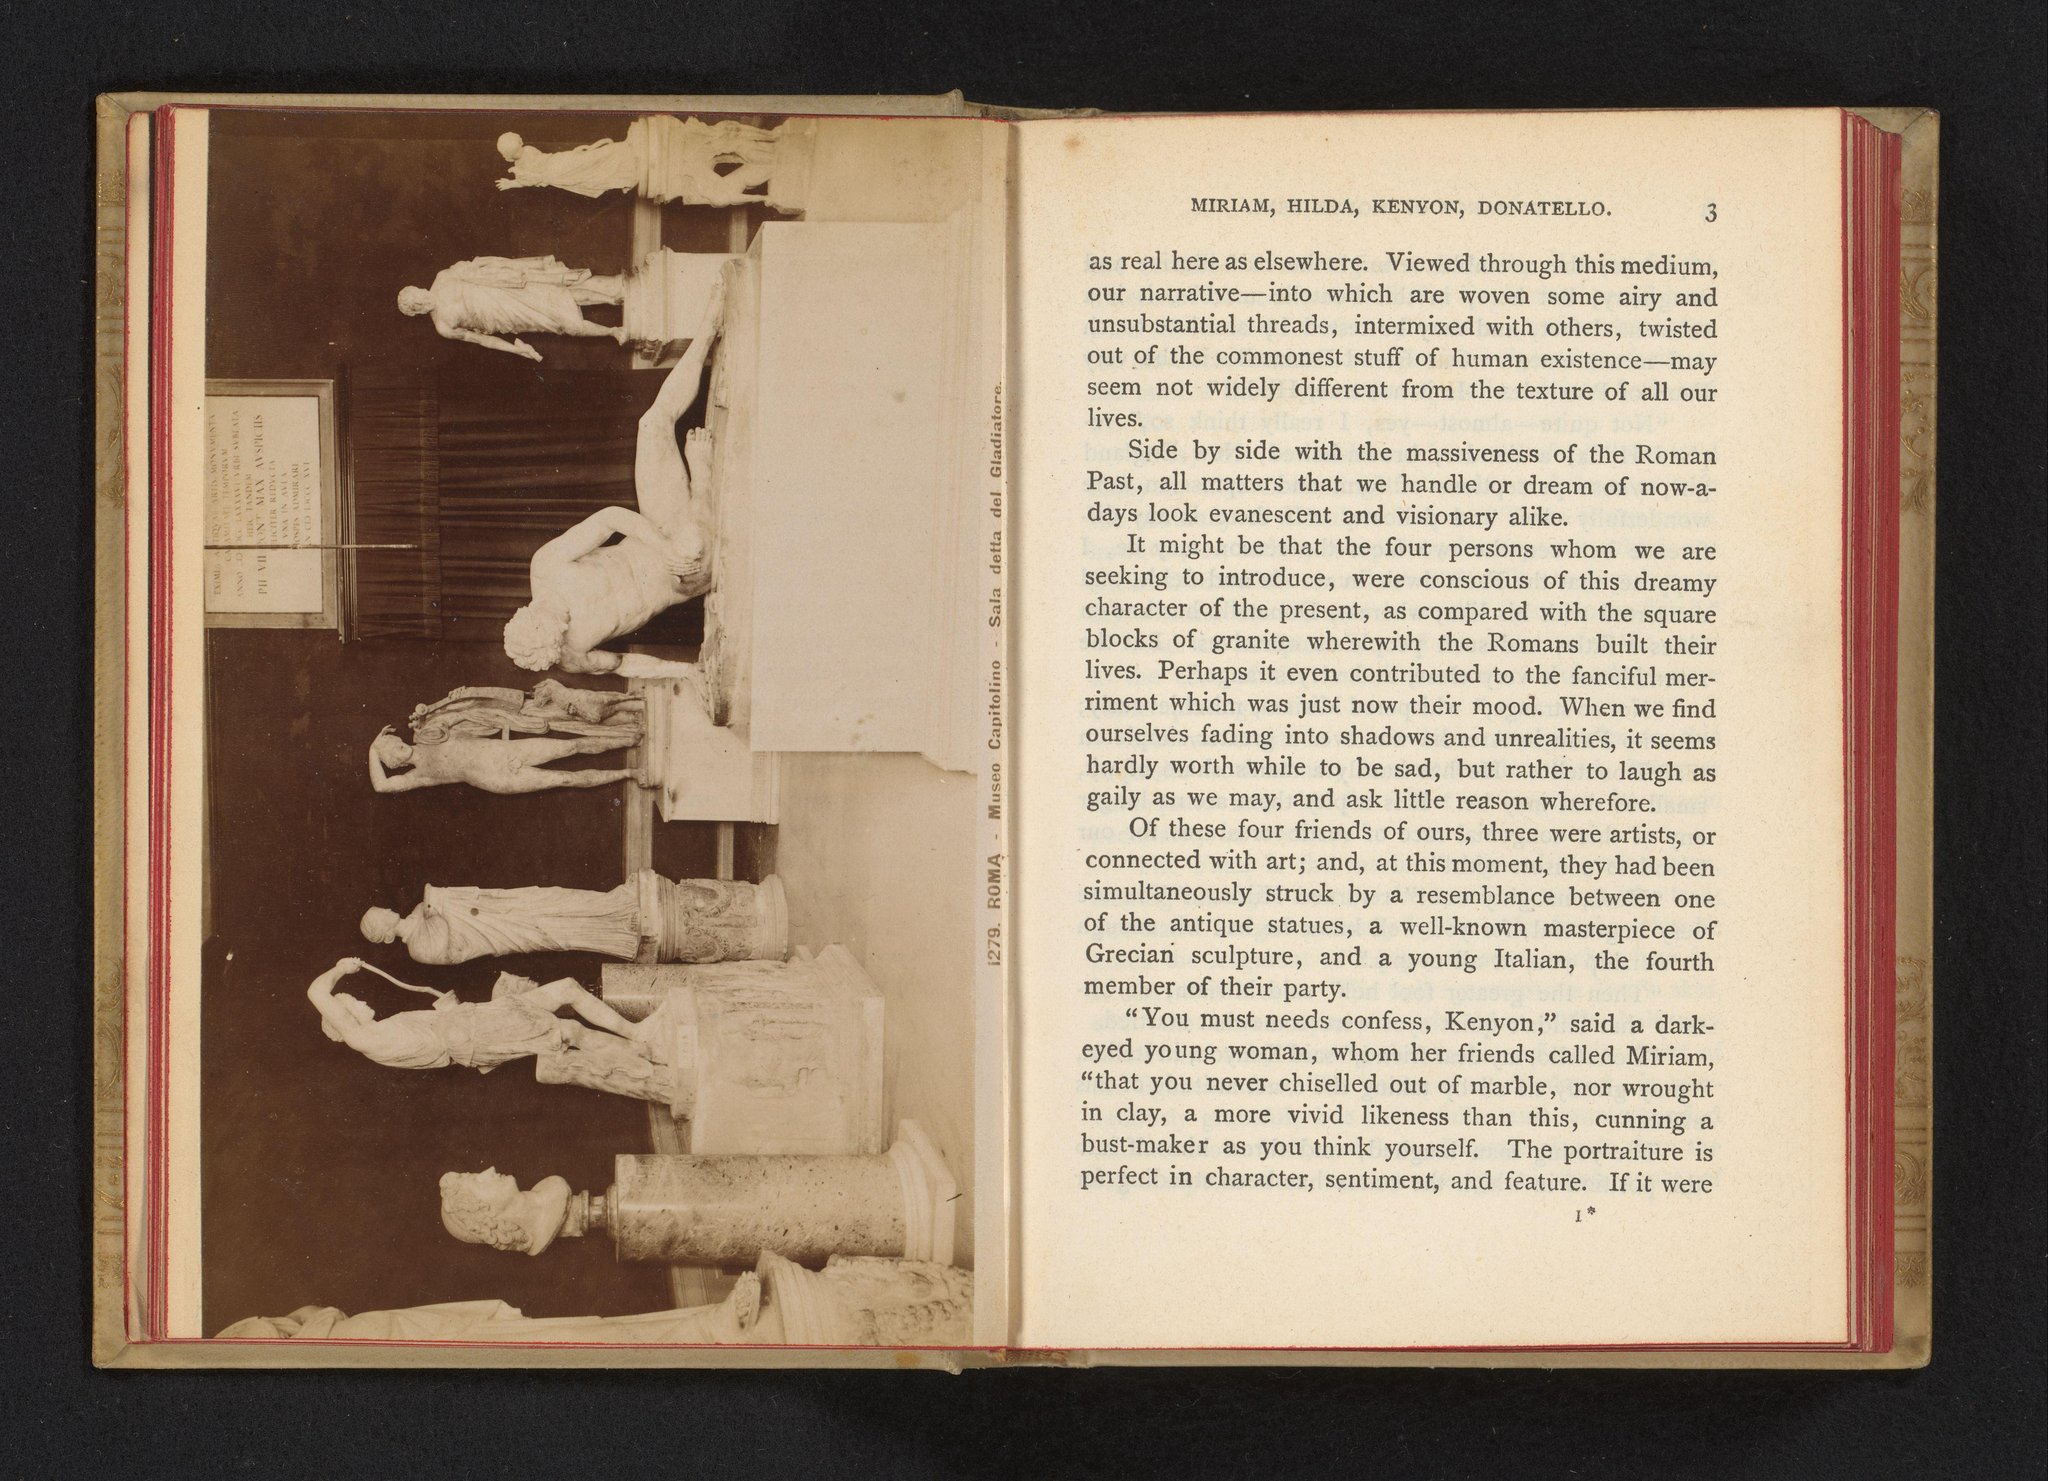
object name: page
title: Beeldengalerij in de Capitolijnse Musea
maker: Anonymous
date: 1855-1860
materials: paper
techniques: albumen print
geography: capitolijnse musea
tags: permanent exhibition, museum, sculpture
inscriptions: number: ‘1279.’